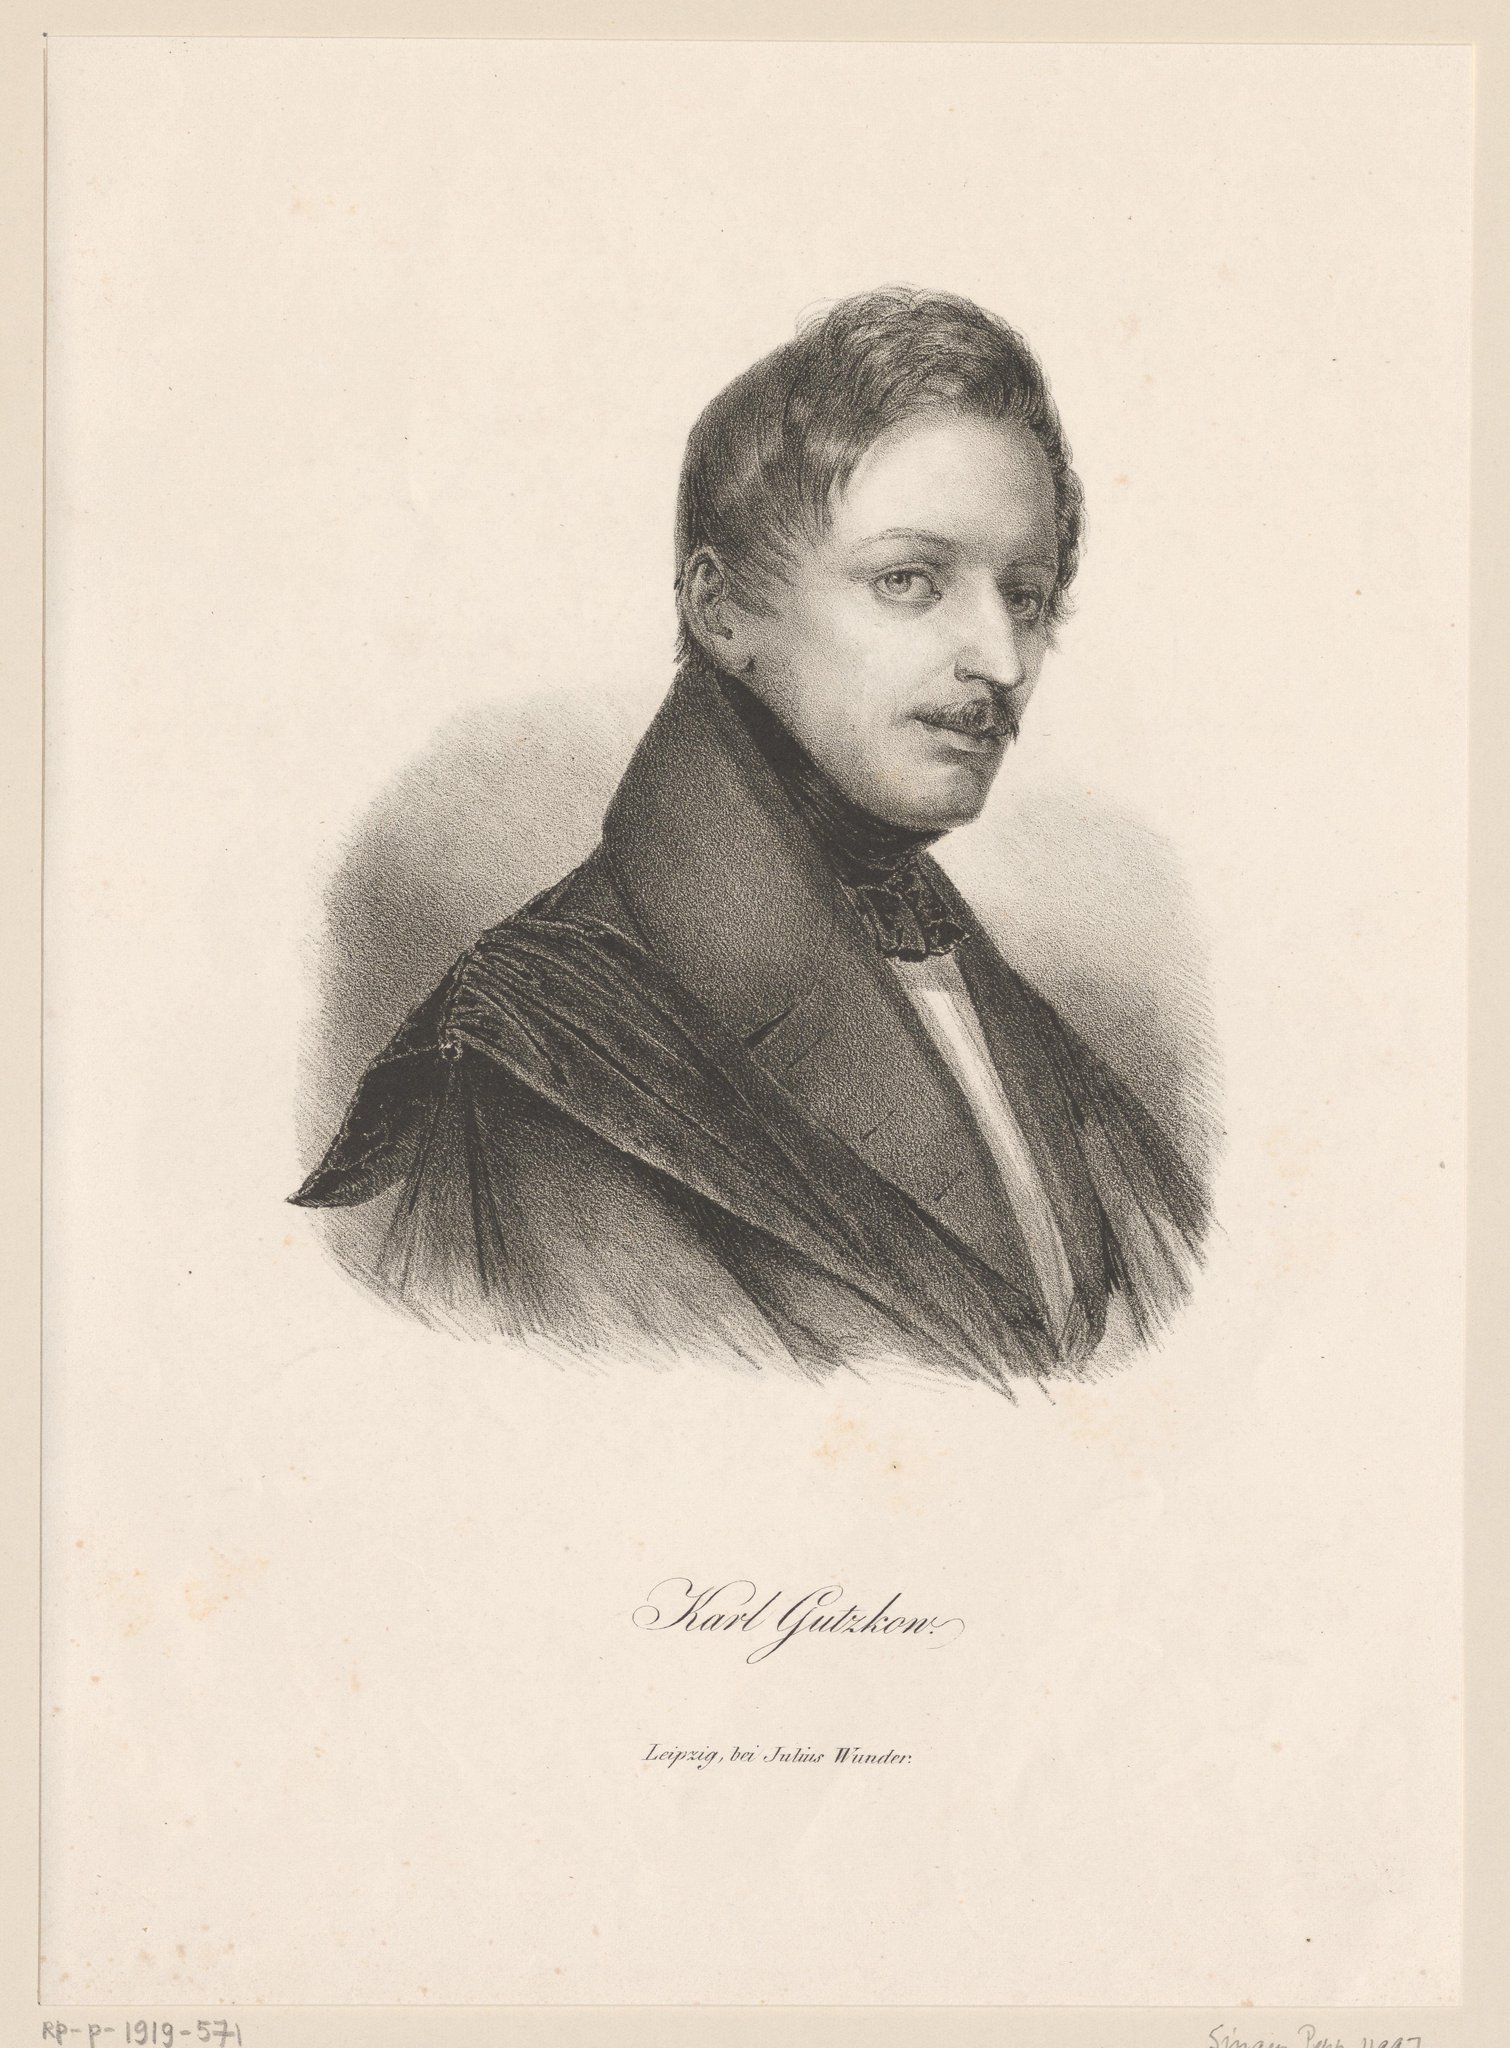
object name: print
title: Portret van Karl Gutzkow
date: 1821-1878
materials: paper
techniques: lithograph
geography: leipzig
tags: historical persons, professor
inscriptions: collector's mark: Lugt 2228